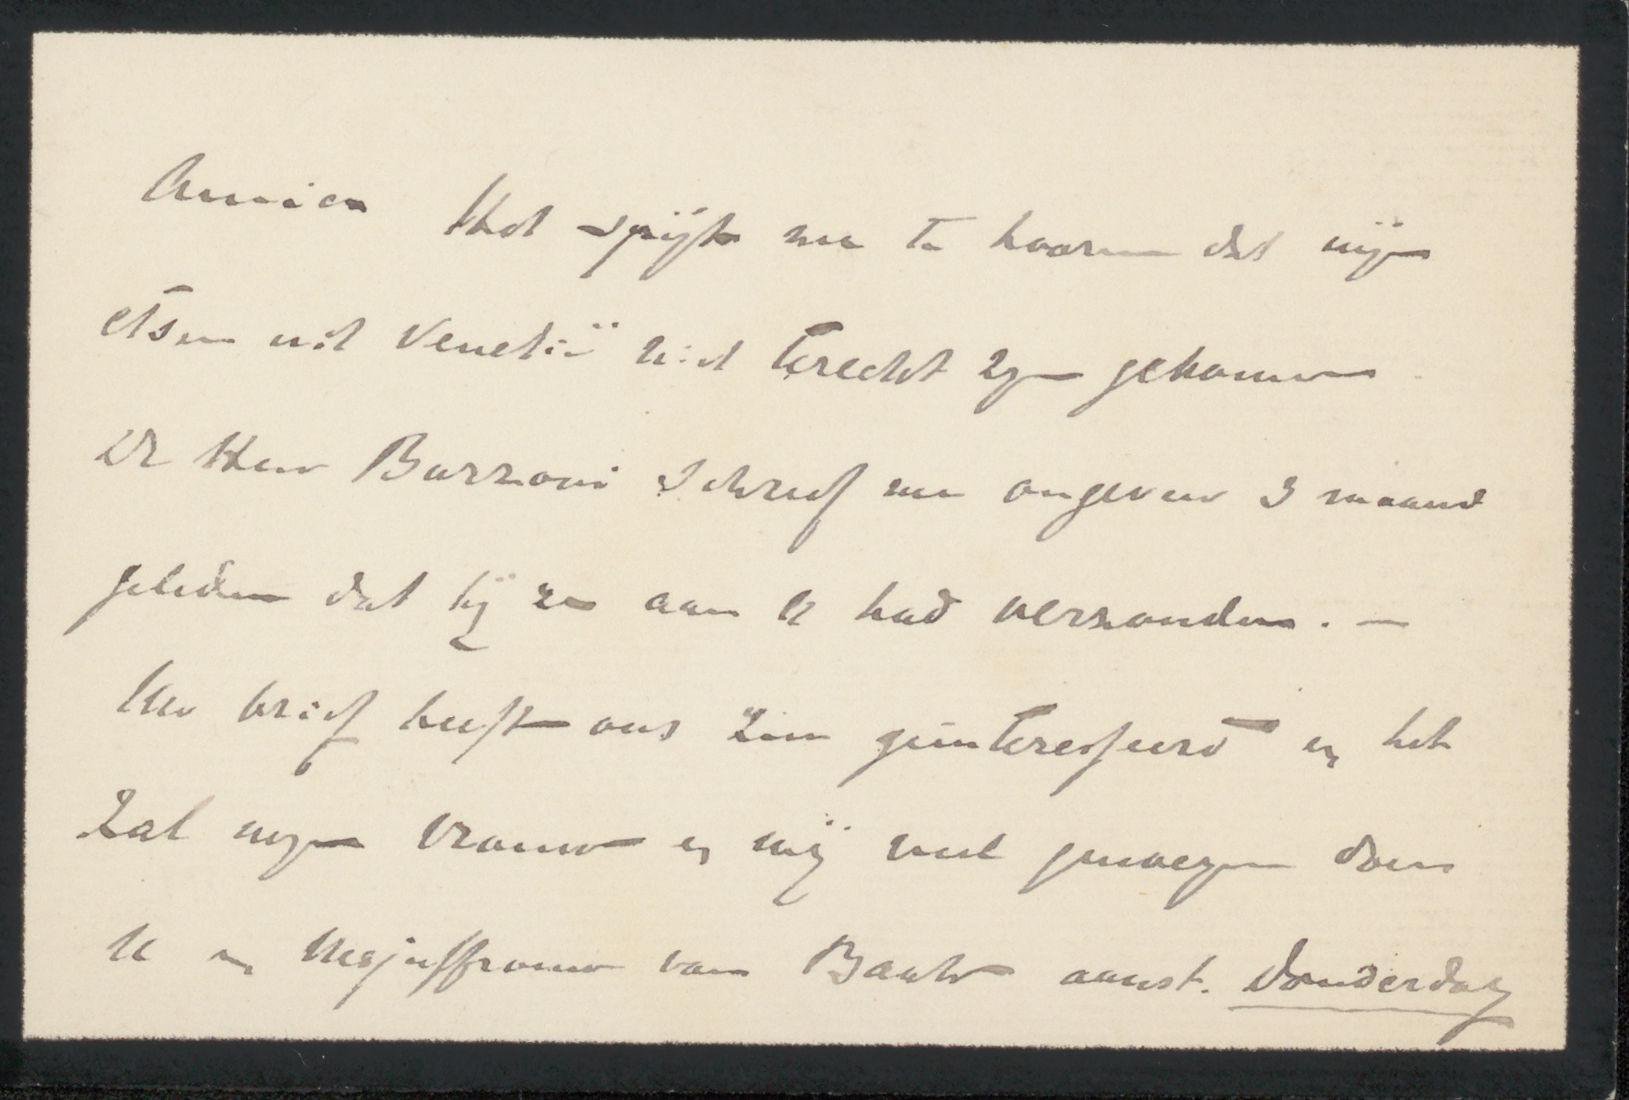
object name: letter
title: Brief aan Philip Zilcken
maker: carel nicolaas storm van s-gravesande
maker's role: draughtsman, print maker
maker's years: 1841-1924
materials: cardboard, ink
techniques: pen, writing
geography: the hague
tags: painter, draughtsman, philip zilcken, the graphic arts, exhibition ~ art, venice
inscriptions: collector's mark: ‘RPK’